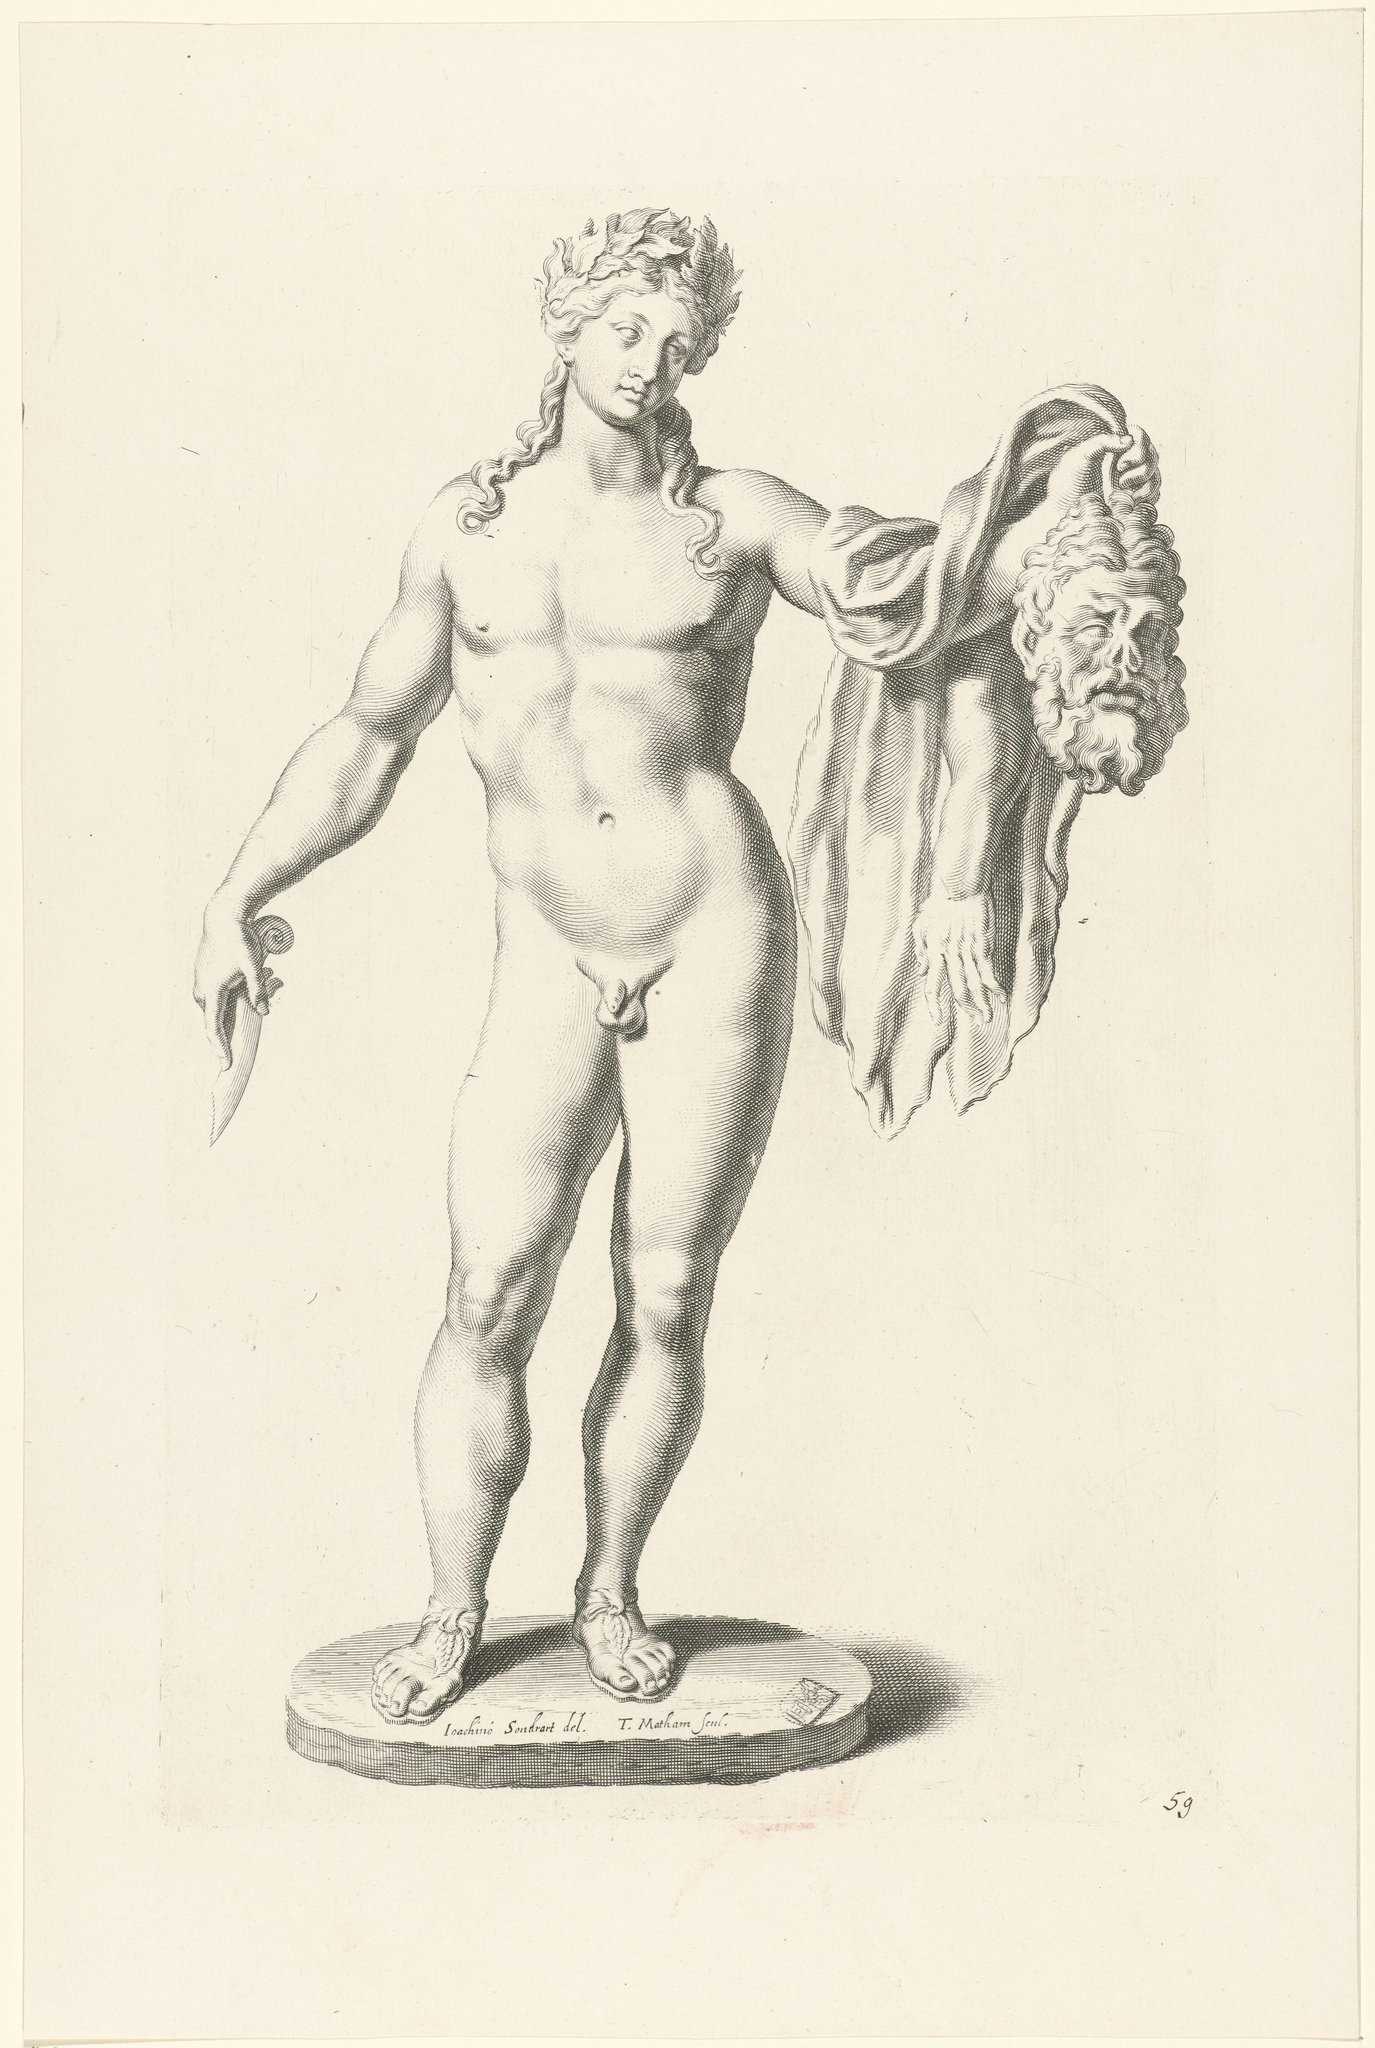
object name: print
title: Galleria Giustiniana del Marchese Vincenzo Giustiniani I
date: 1640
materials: paper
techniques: engraving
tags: rome, vincenzo giustiniani (1564-1637), (story of) apollo (phoebus), piece of sculpture, reproduction of a piece of sculpture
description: Standbeeld van Apollo met huid van Marsyas. Op de voet het wapenschild van Vincenzo Giustiniani. Prent uit een publicatie met reproductieprenten naar de sculpturen in de verzameling in de Galleria Giustiniani te Rome.